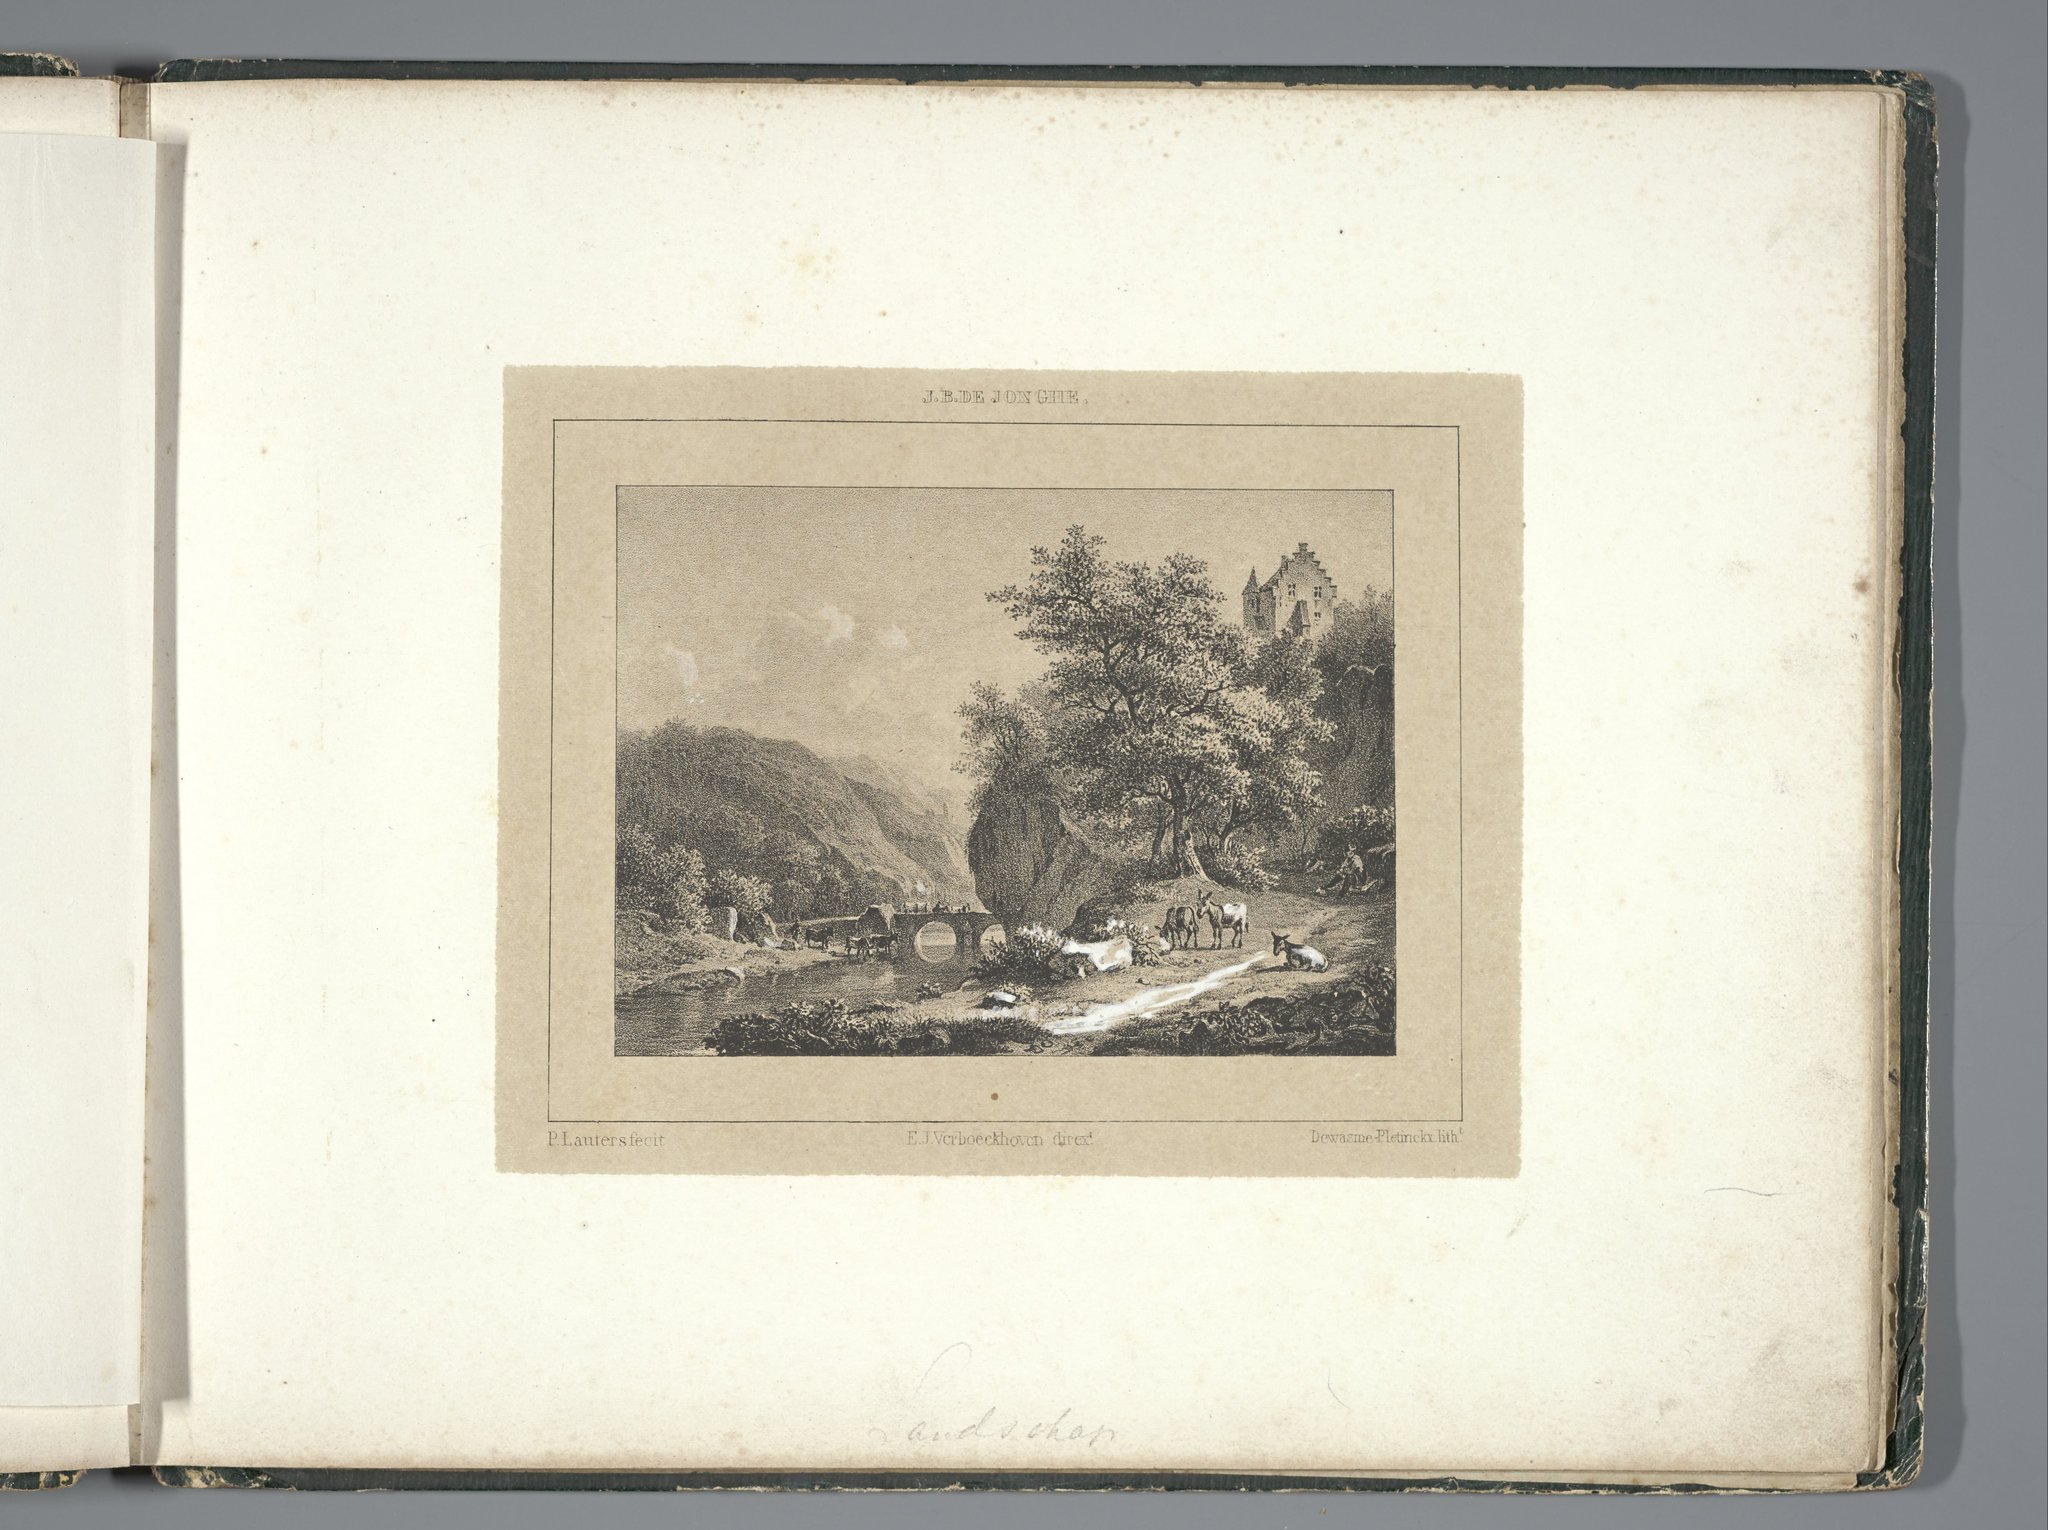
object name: print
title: Landschap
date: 1830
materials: paper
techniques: lithograph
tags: landscapes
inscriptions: inscription: ‘Landschap’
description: Prent uit album met twaalf vroege lithografieën geproduceerd door de firma Dewasme-Pletinckx te Brussel naar J.C. Schotel, E.J. Verboeckhoven, B.J. van Hove en andere eigentijdse meesters in originele band.